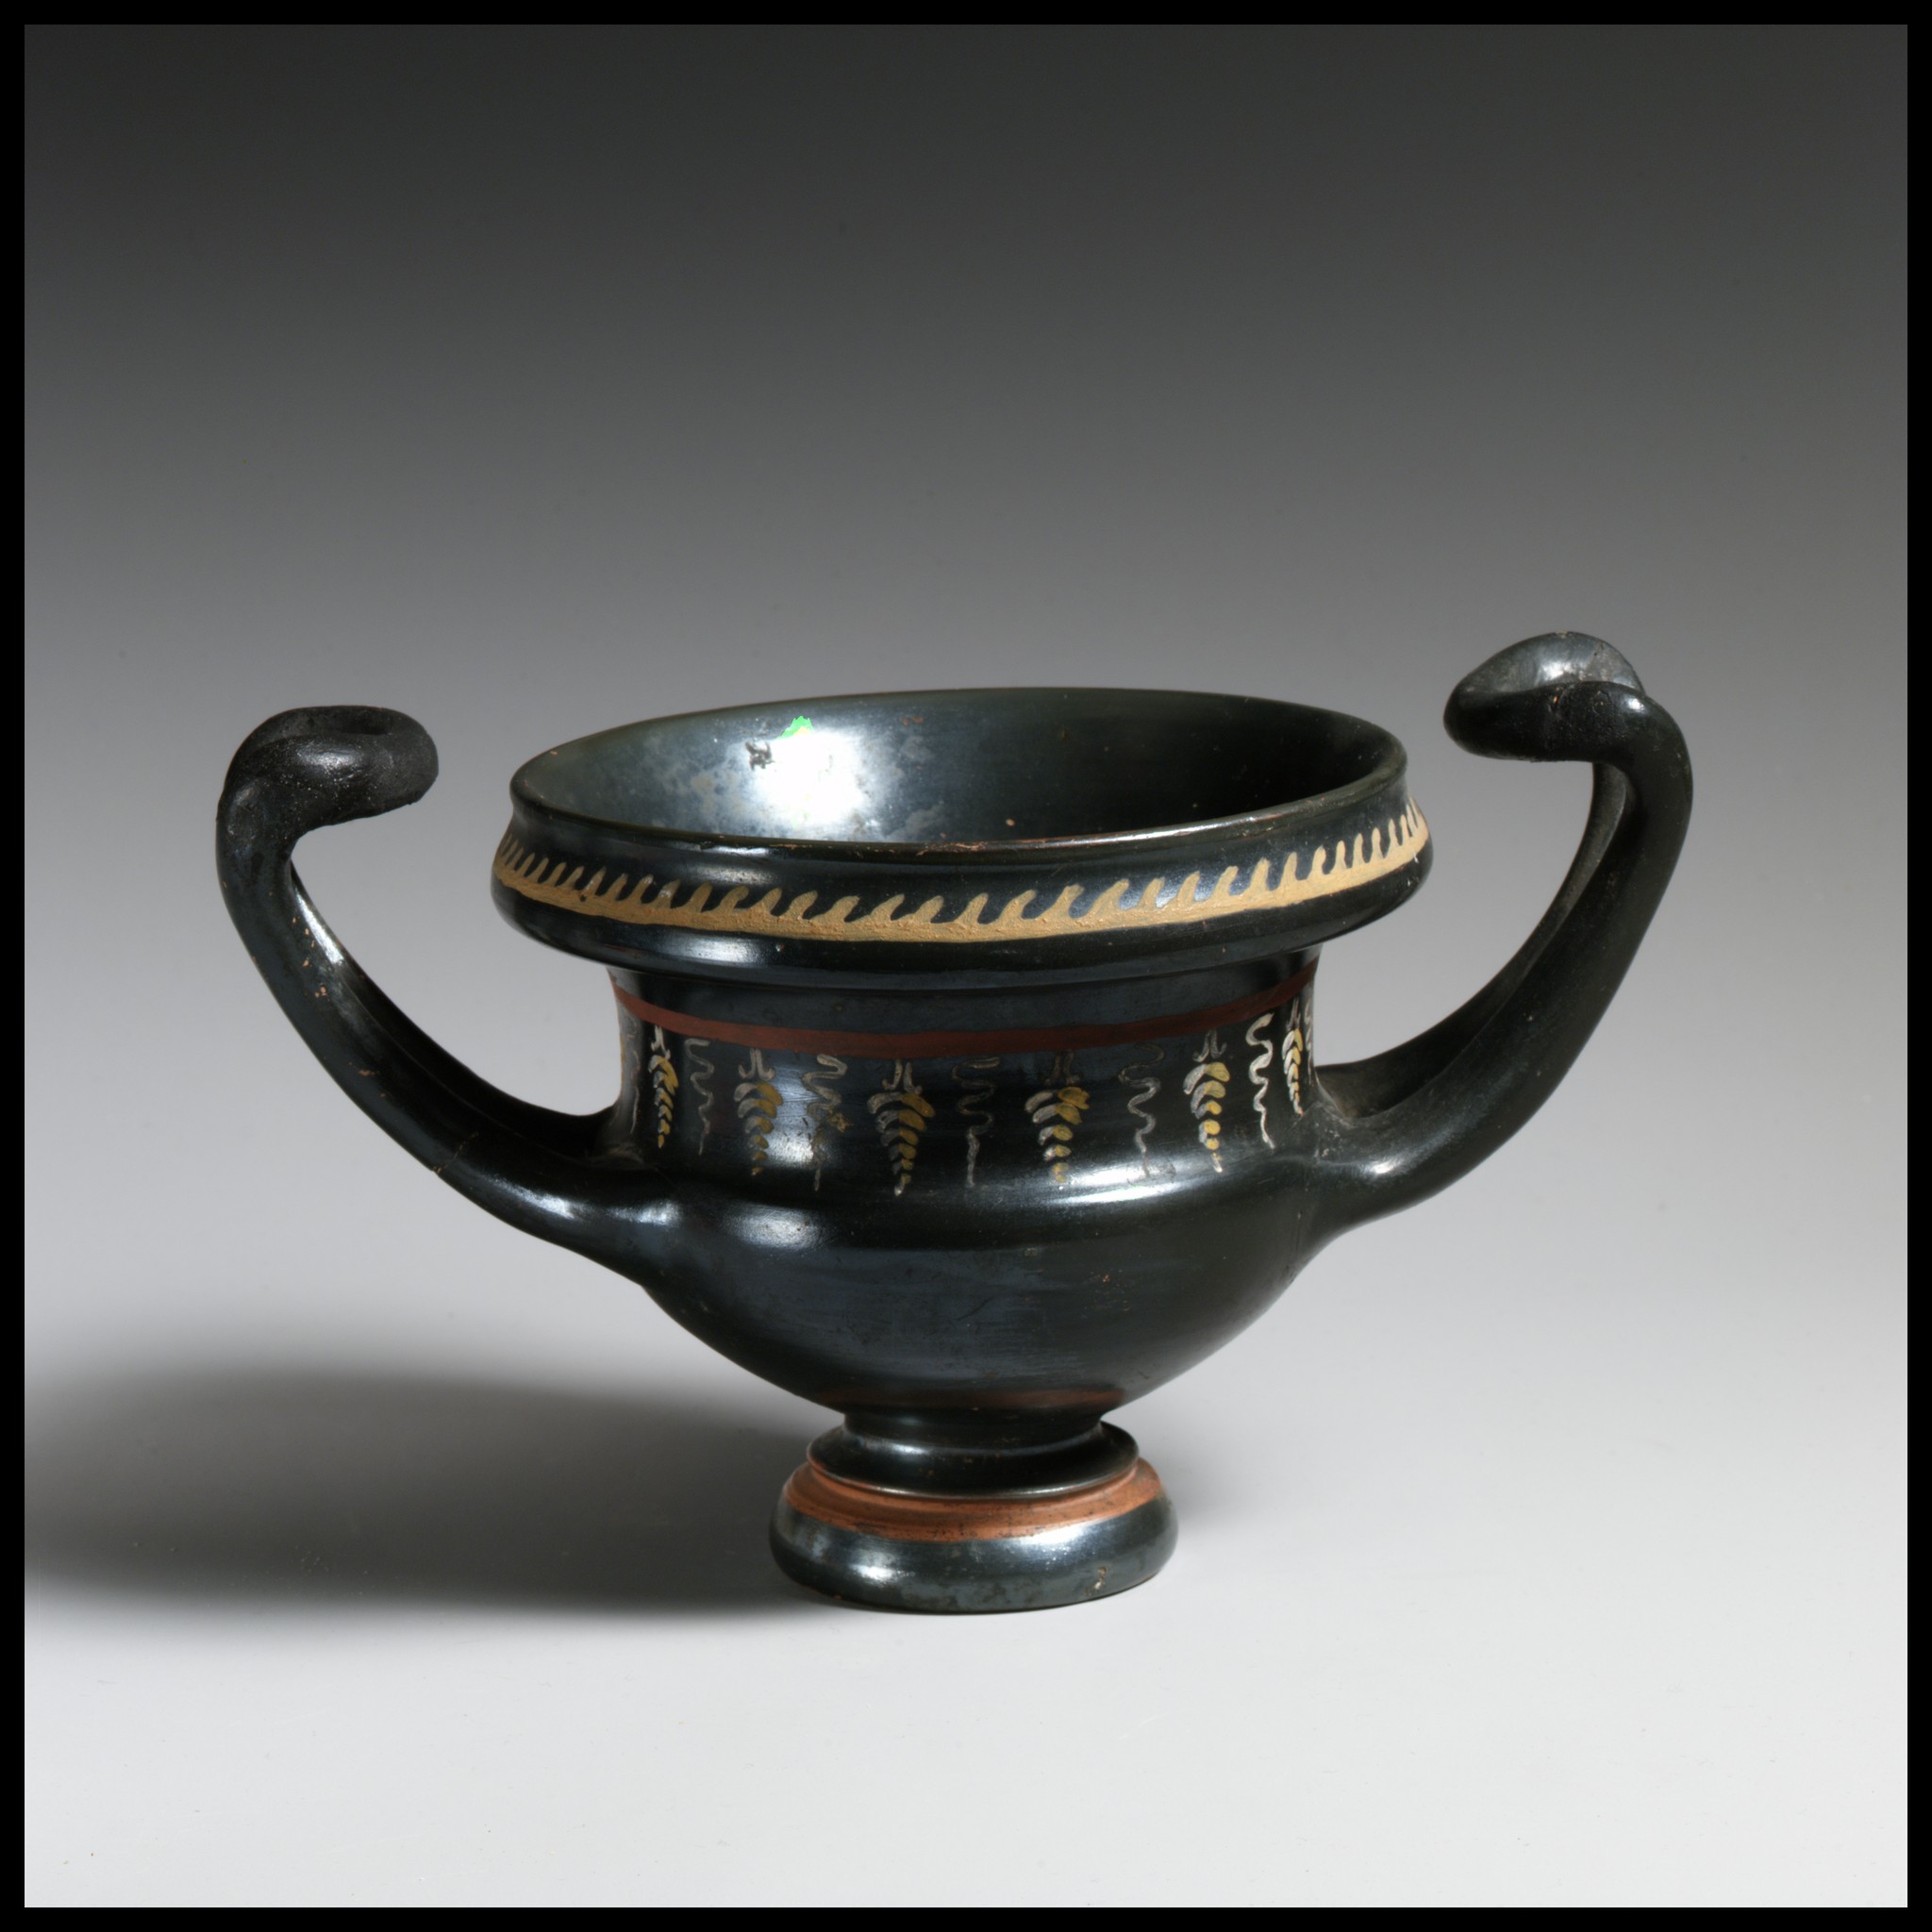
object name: skyphos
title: Terracotta cup-skyphos (drinking cup)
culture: greek, south italian, apulian, gnathian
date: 334-301 BCE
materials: terracotta